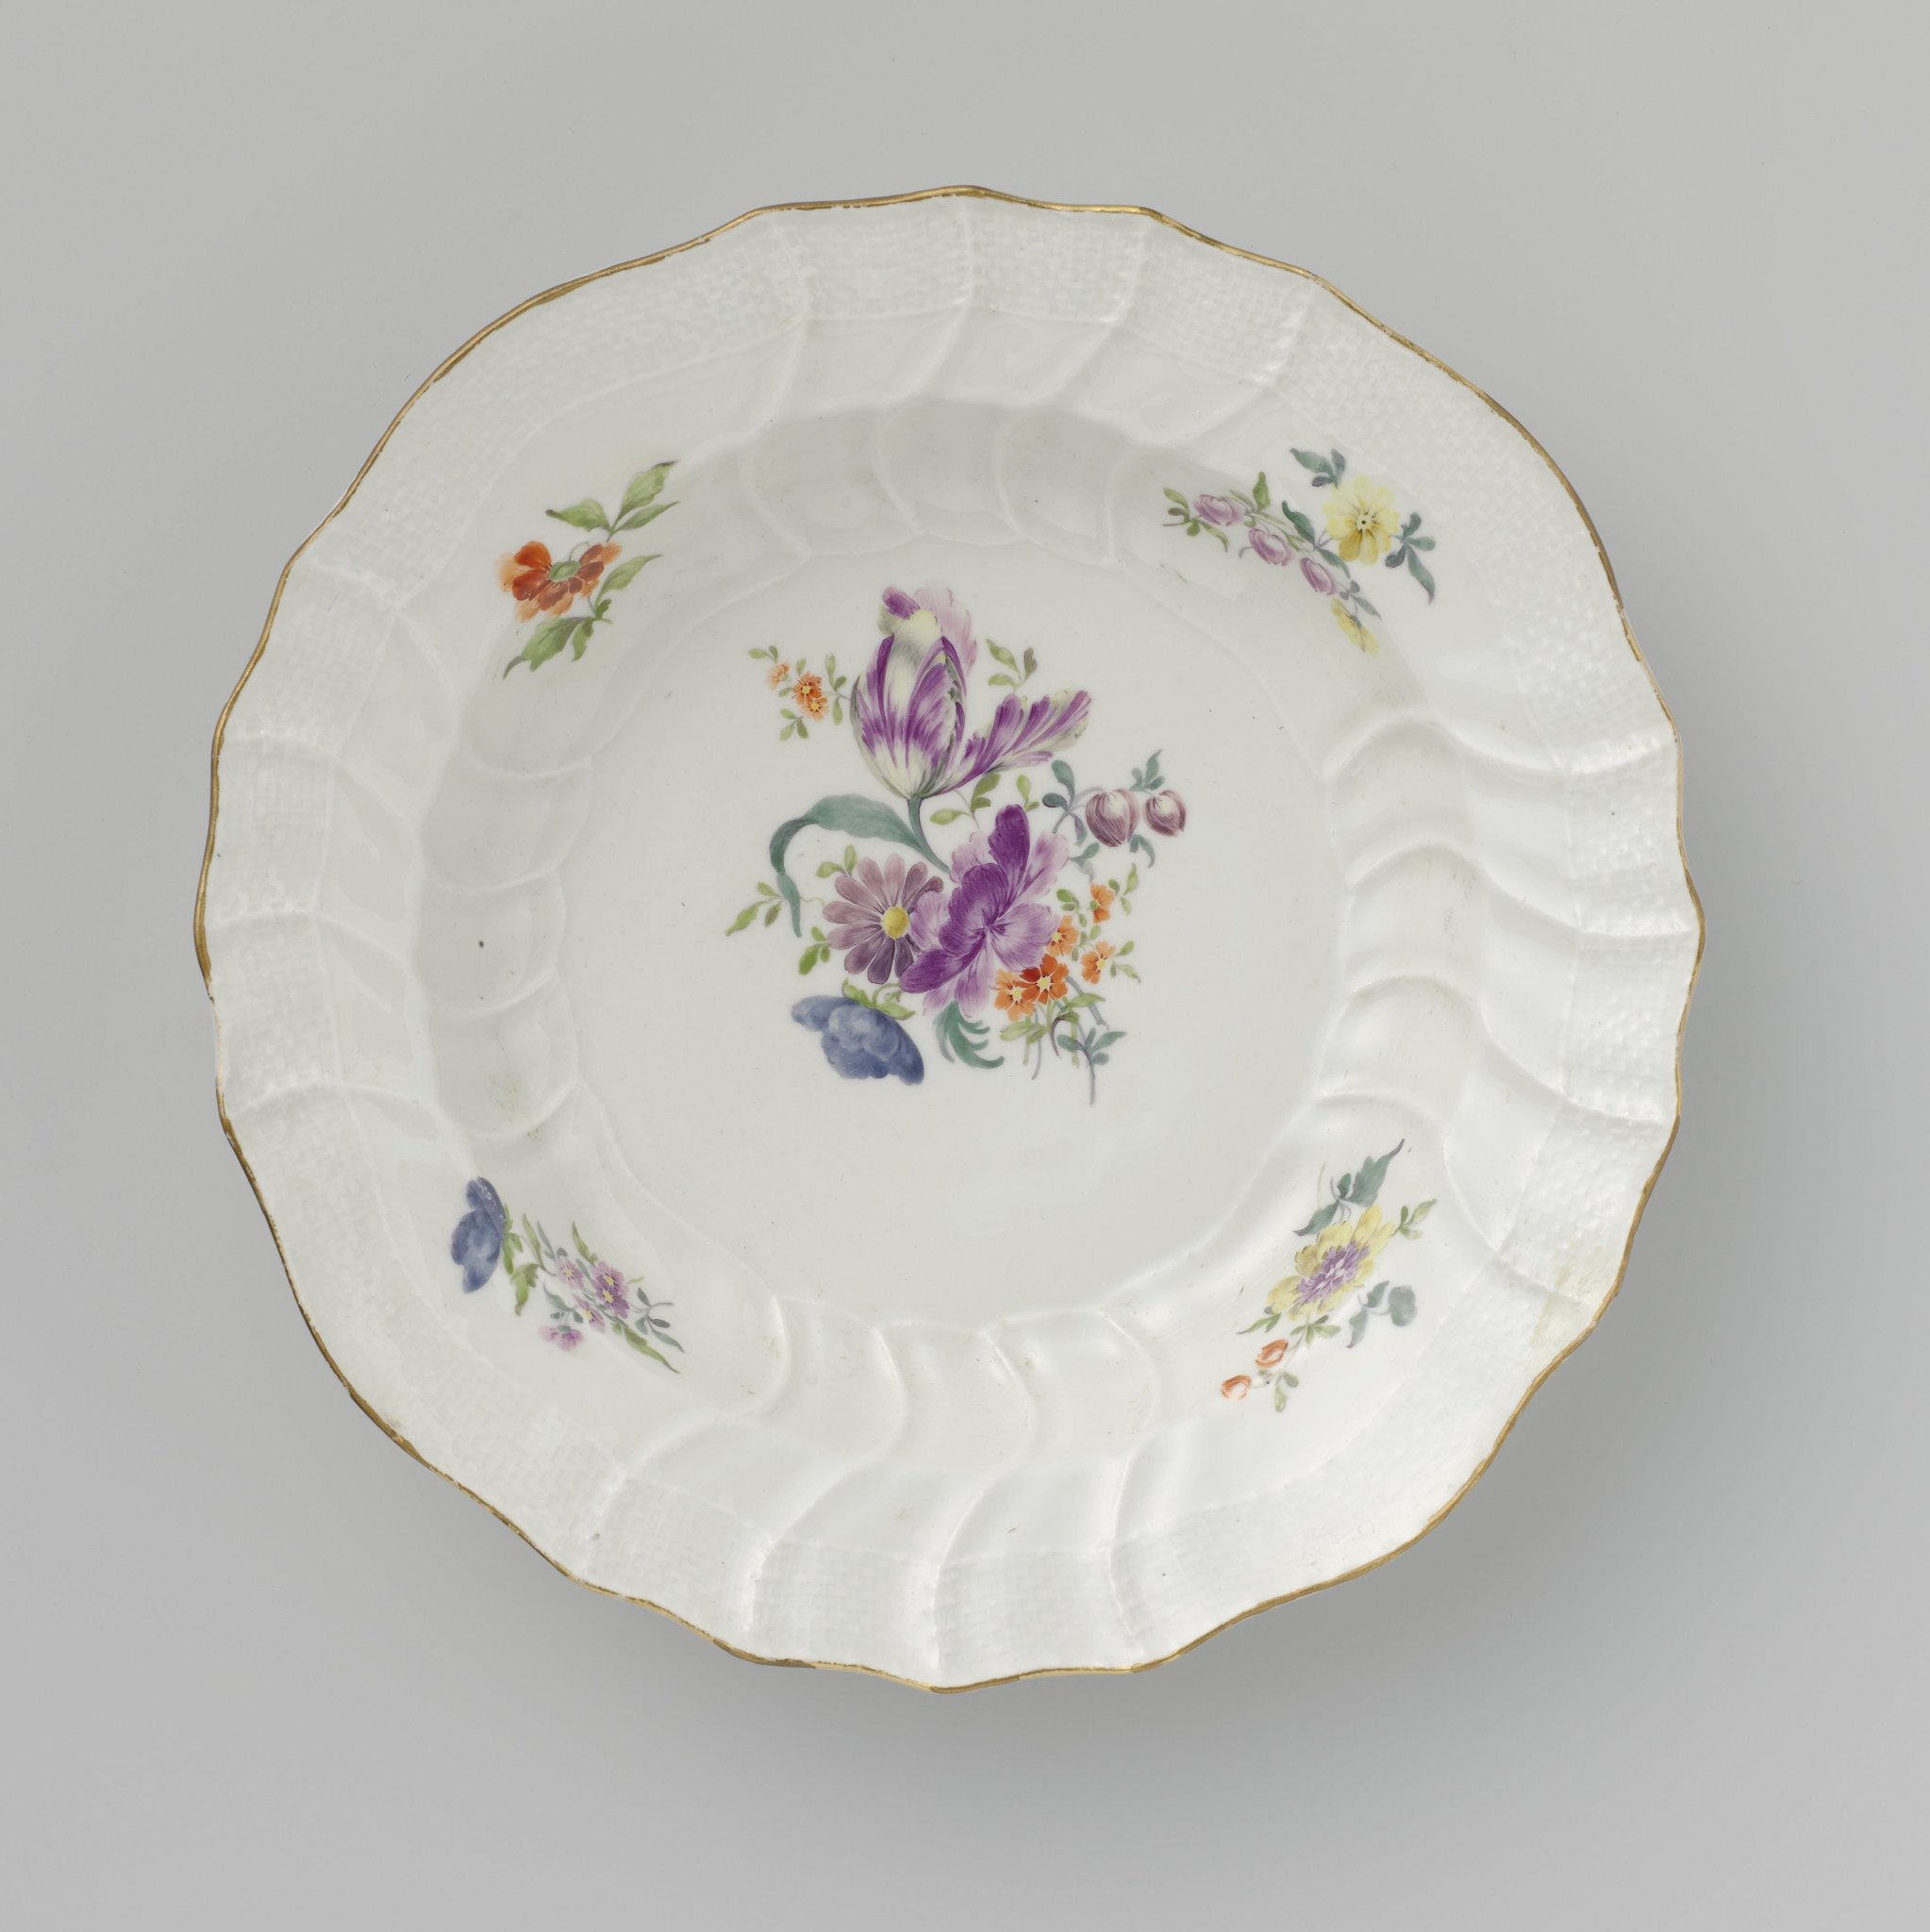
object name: eating drinking utensil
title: Bord, veelkleurig beschilderd met Deutsche Blumen, insekten en vruchten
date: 1750-1760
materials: porcelain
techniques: painted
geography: meissen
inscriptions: factory mark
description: Rond soepbord van beschilderd porselein. Het bord is beschilderd met Deutsche Blumen, insekten en vruchten. De rand is in reliëf versierd met het Neuozier-patroon. Het bord is gemerkt en hoort bij een servies (BK-17474-1 t/m BK-17474-253).